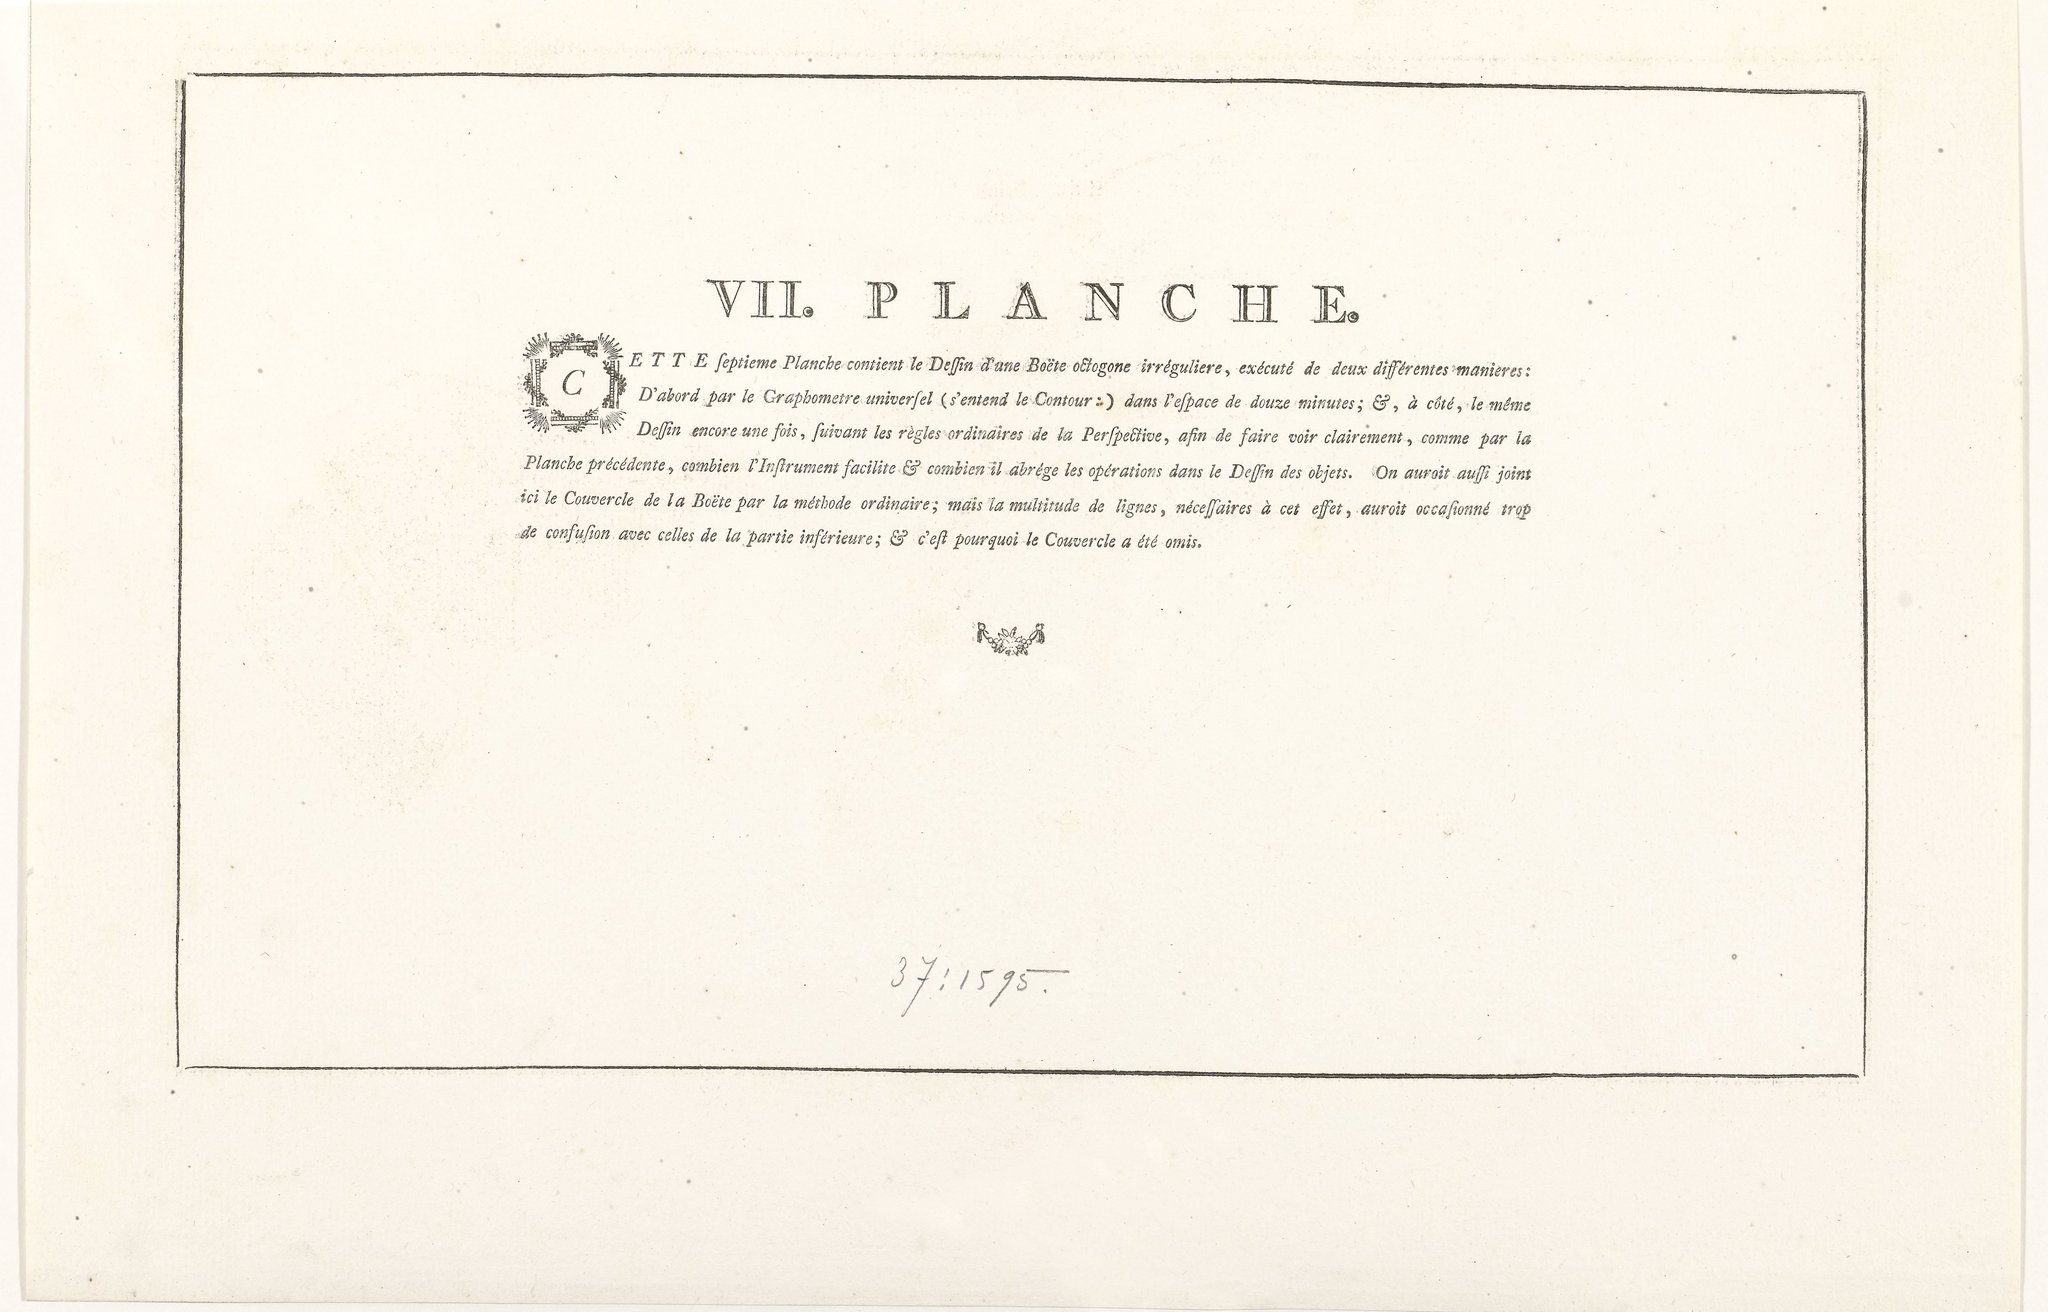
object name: text sheet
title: Toelichting bij een achtkantige doos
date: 1778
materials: paper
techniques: letterpress printing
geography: the hague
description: Tekstblad met een Franstalige toelichting op een prent met een voorstelling van een achtkantige doos, links getekend met behulp van een grafometer en rechts volgens de leer van het perspectief (regels der doorzichtkunde).